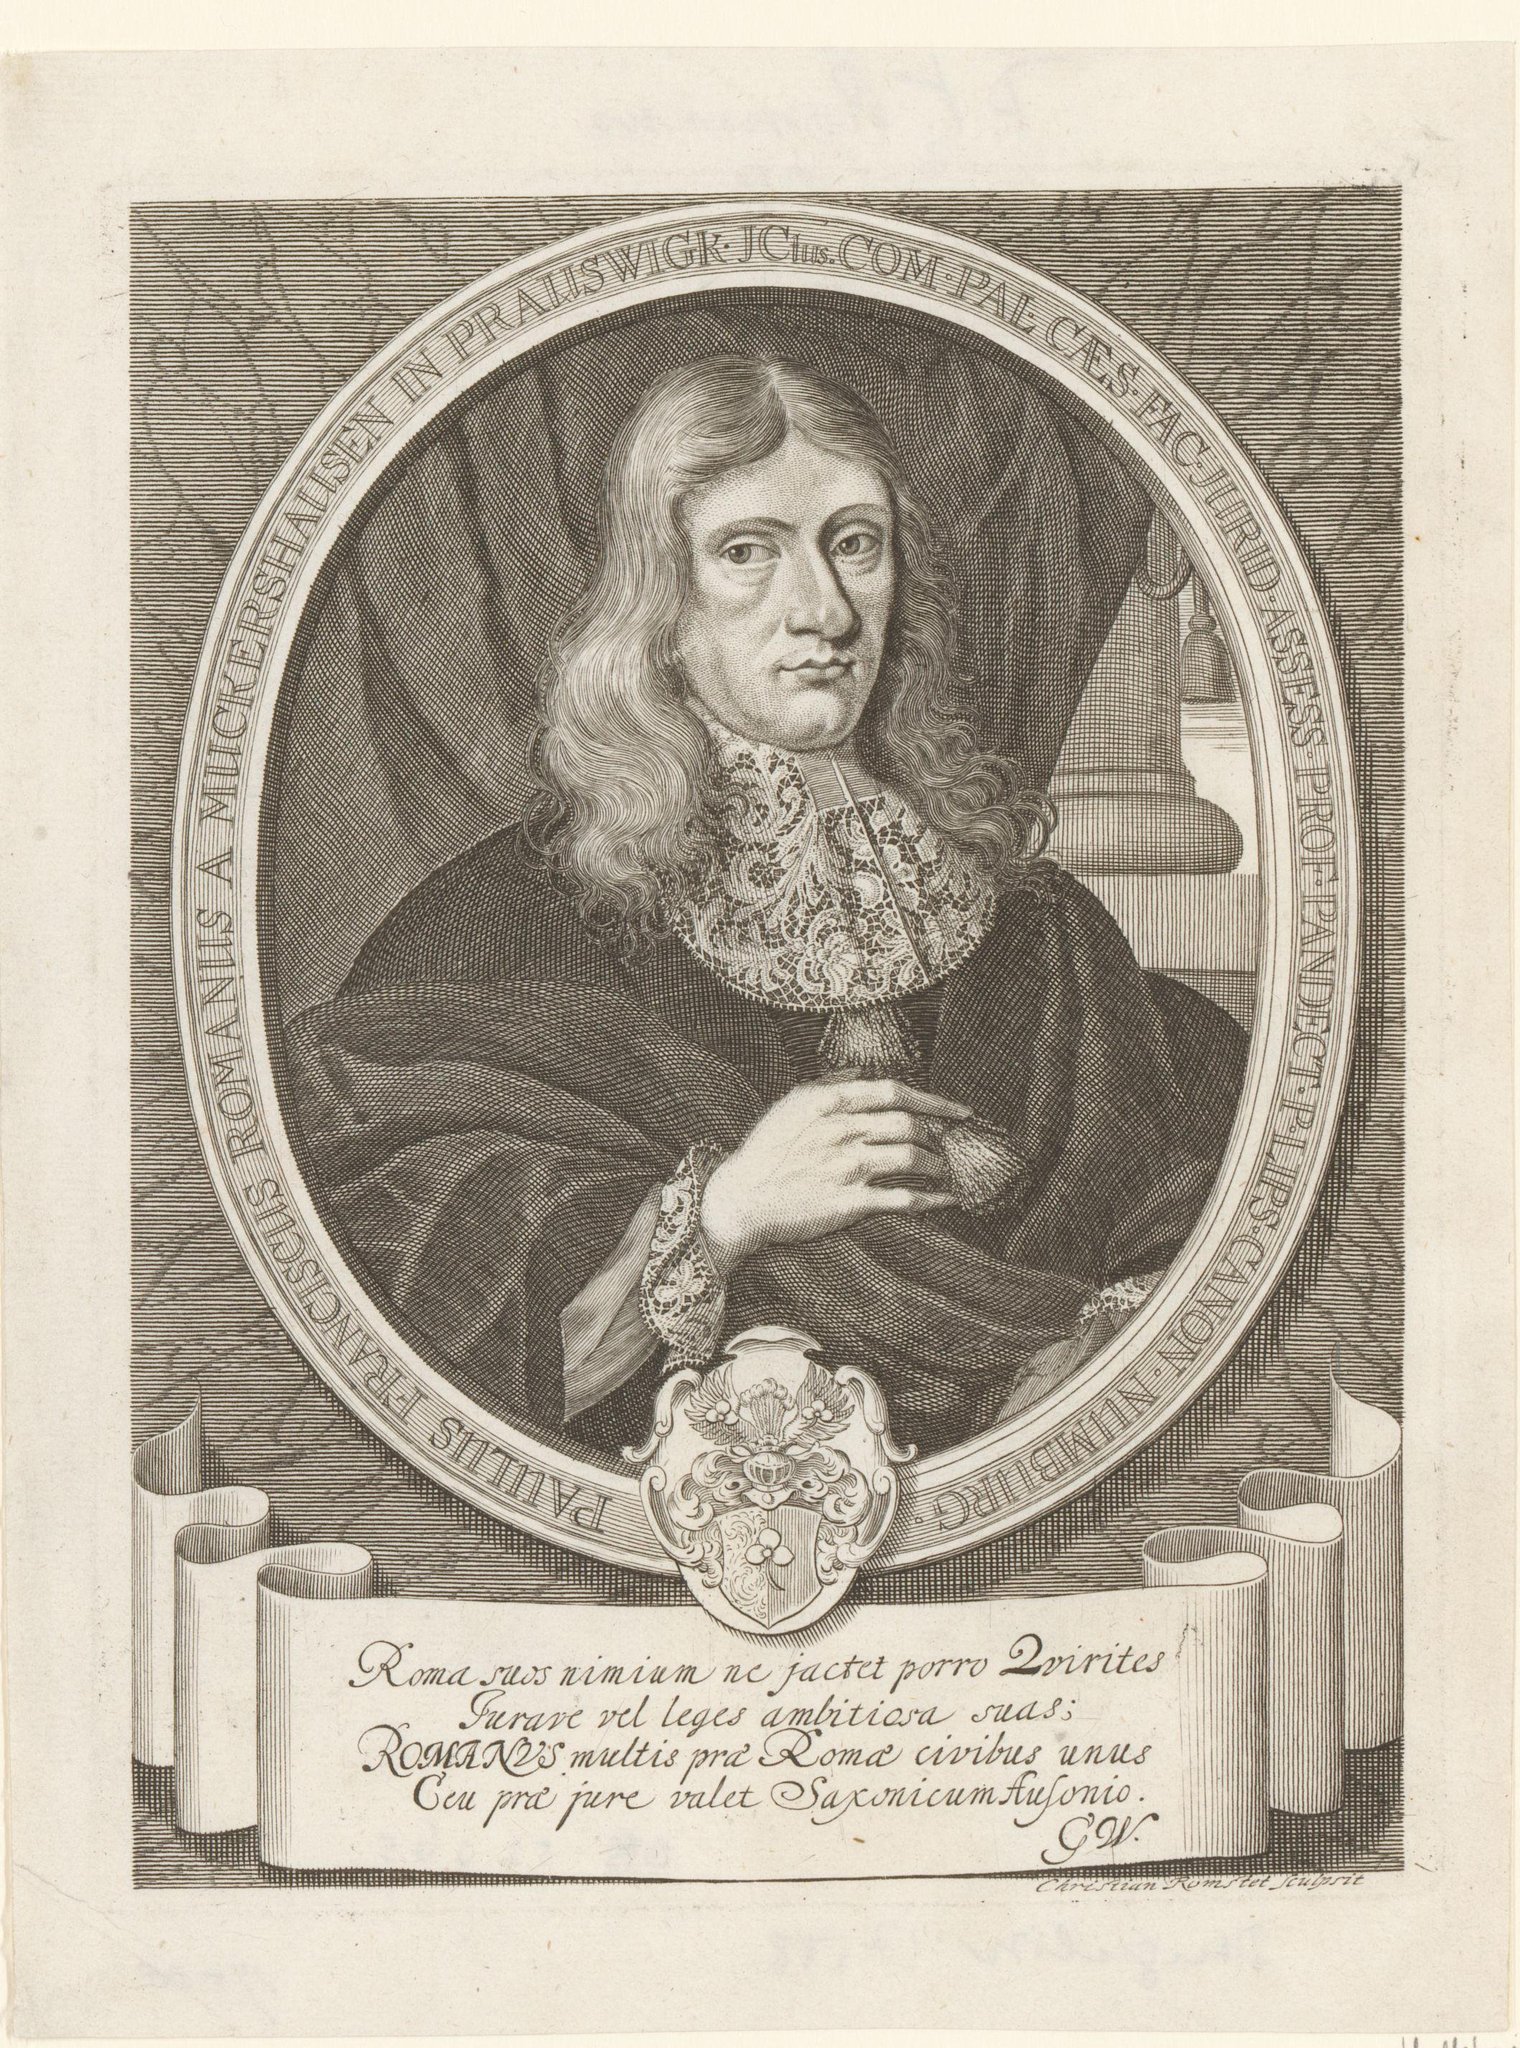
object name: print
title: Portret van Paul Franz Romanus von Muckershausen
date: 1665-1721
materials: paper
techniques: engraving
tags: historical persons, armorial bearing, heraldry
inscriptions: collector's mark: Lugt 2228